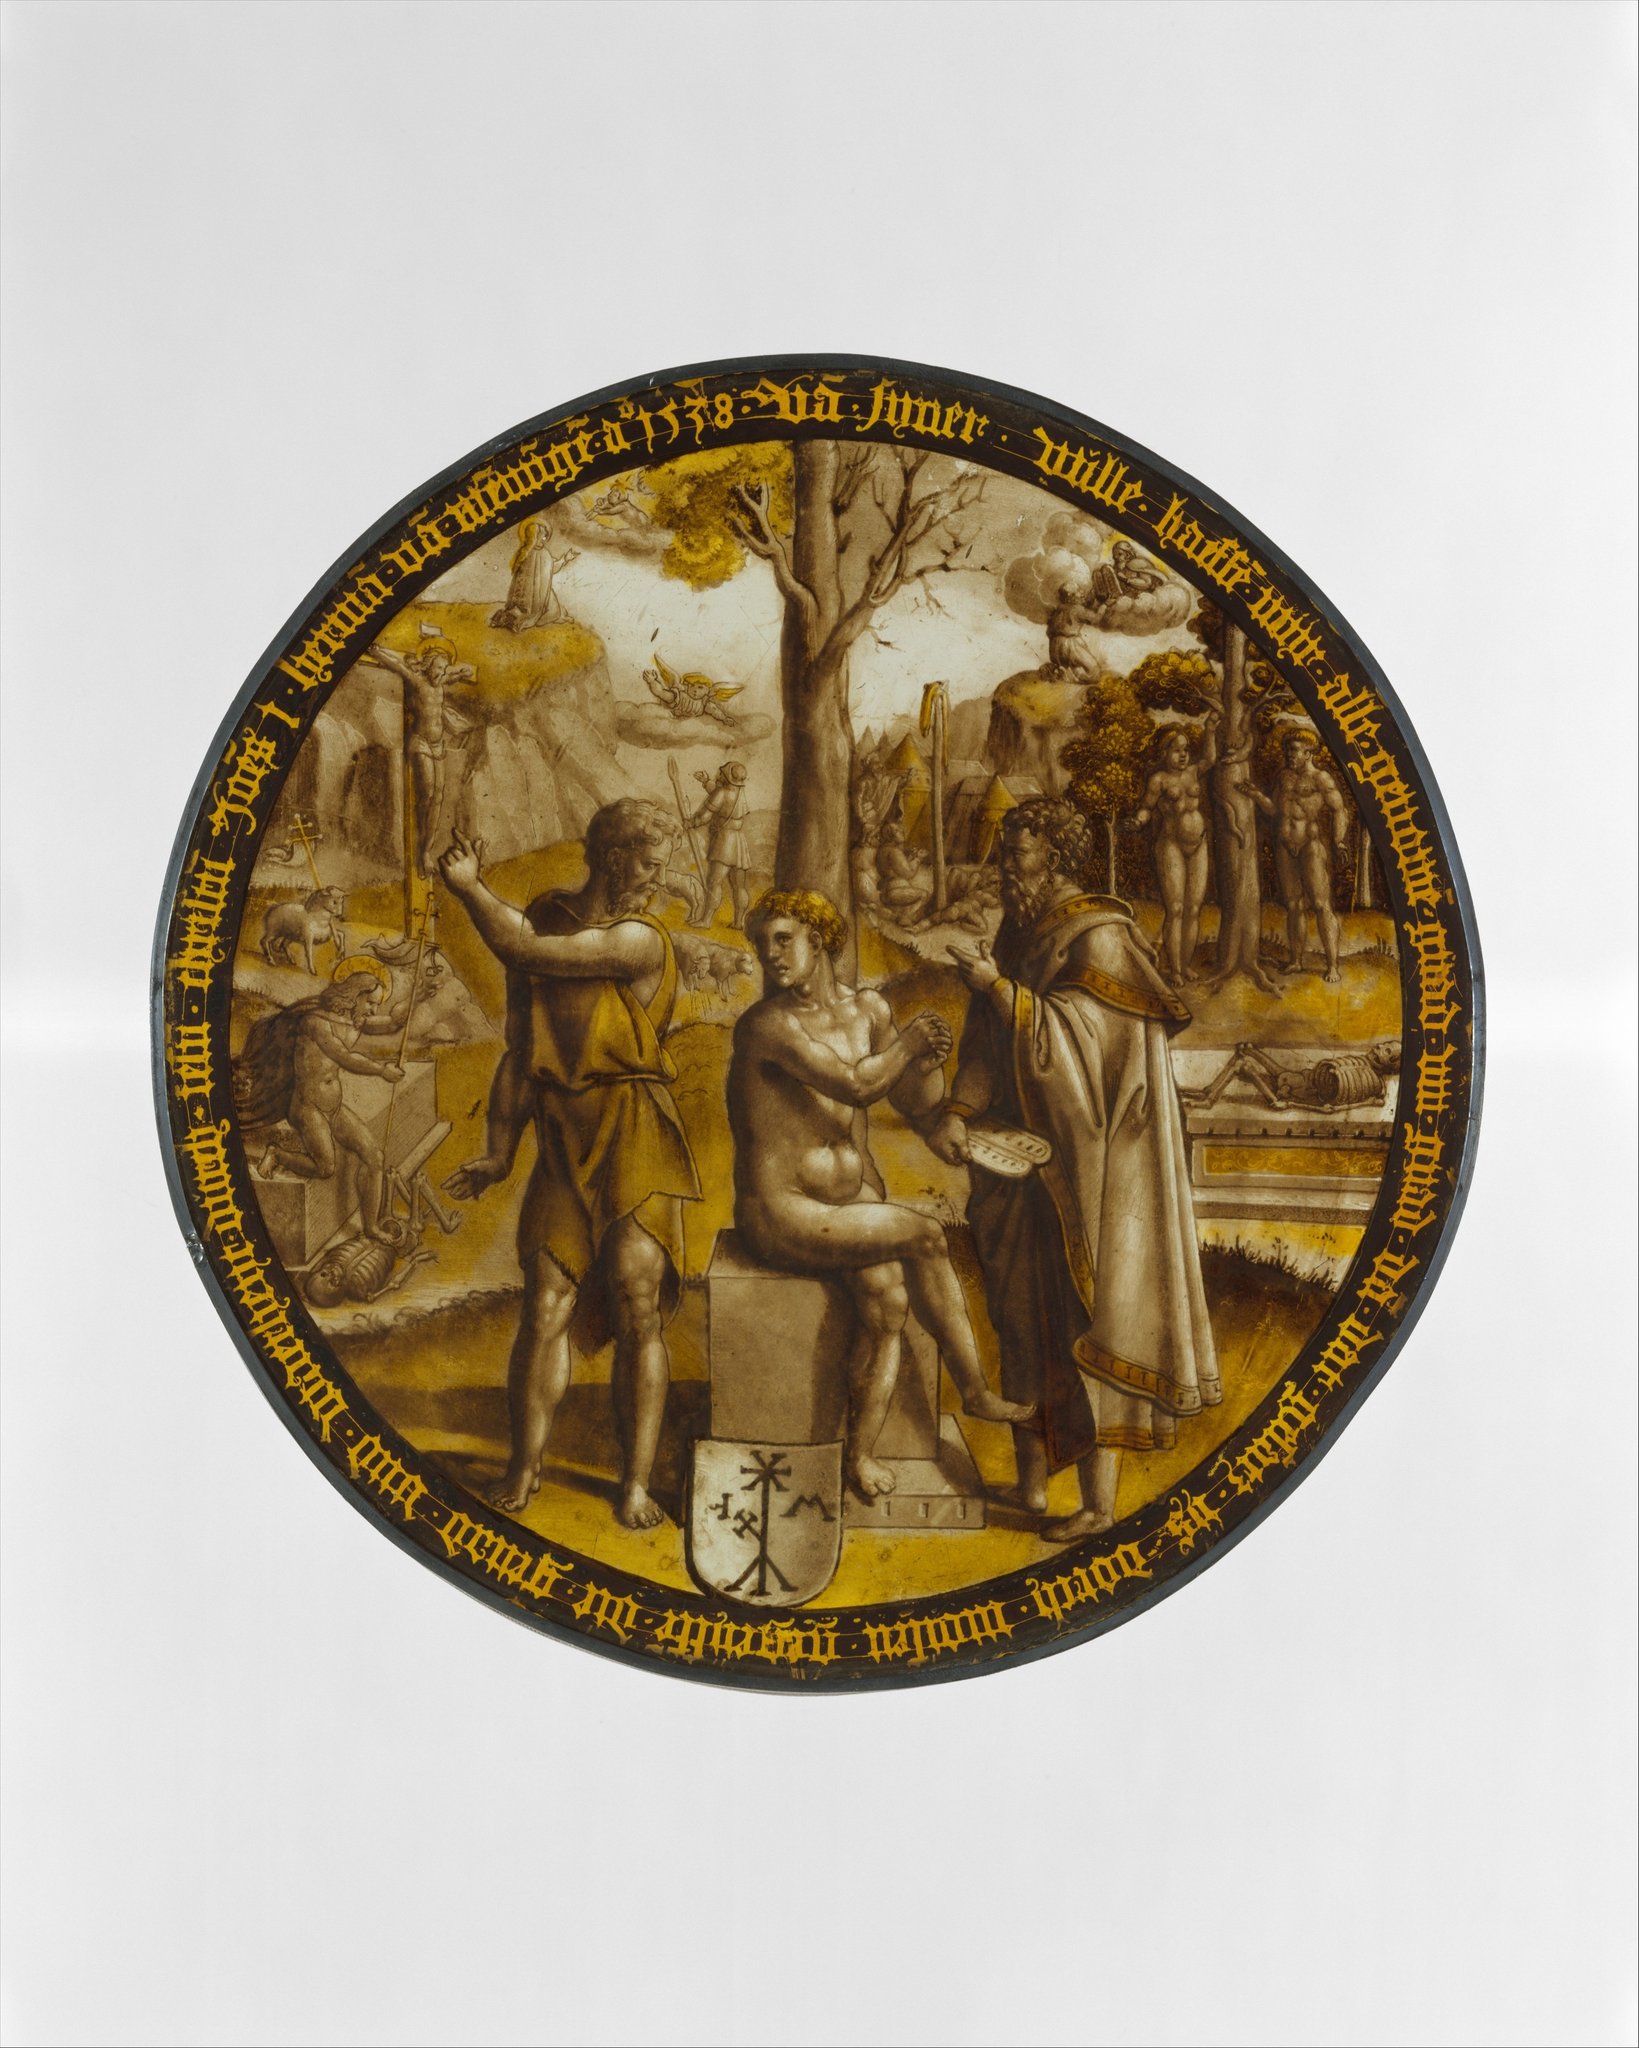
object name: roundel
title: The New and the Old Dispensations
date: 1538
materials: glass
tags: men